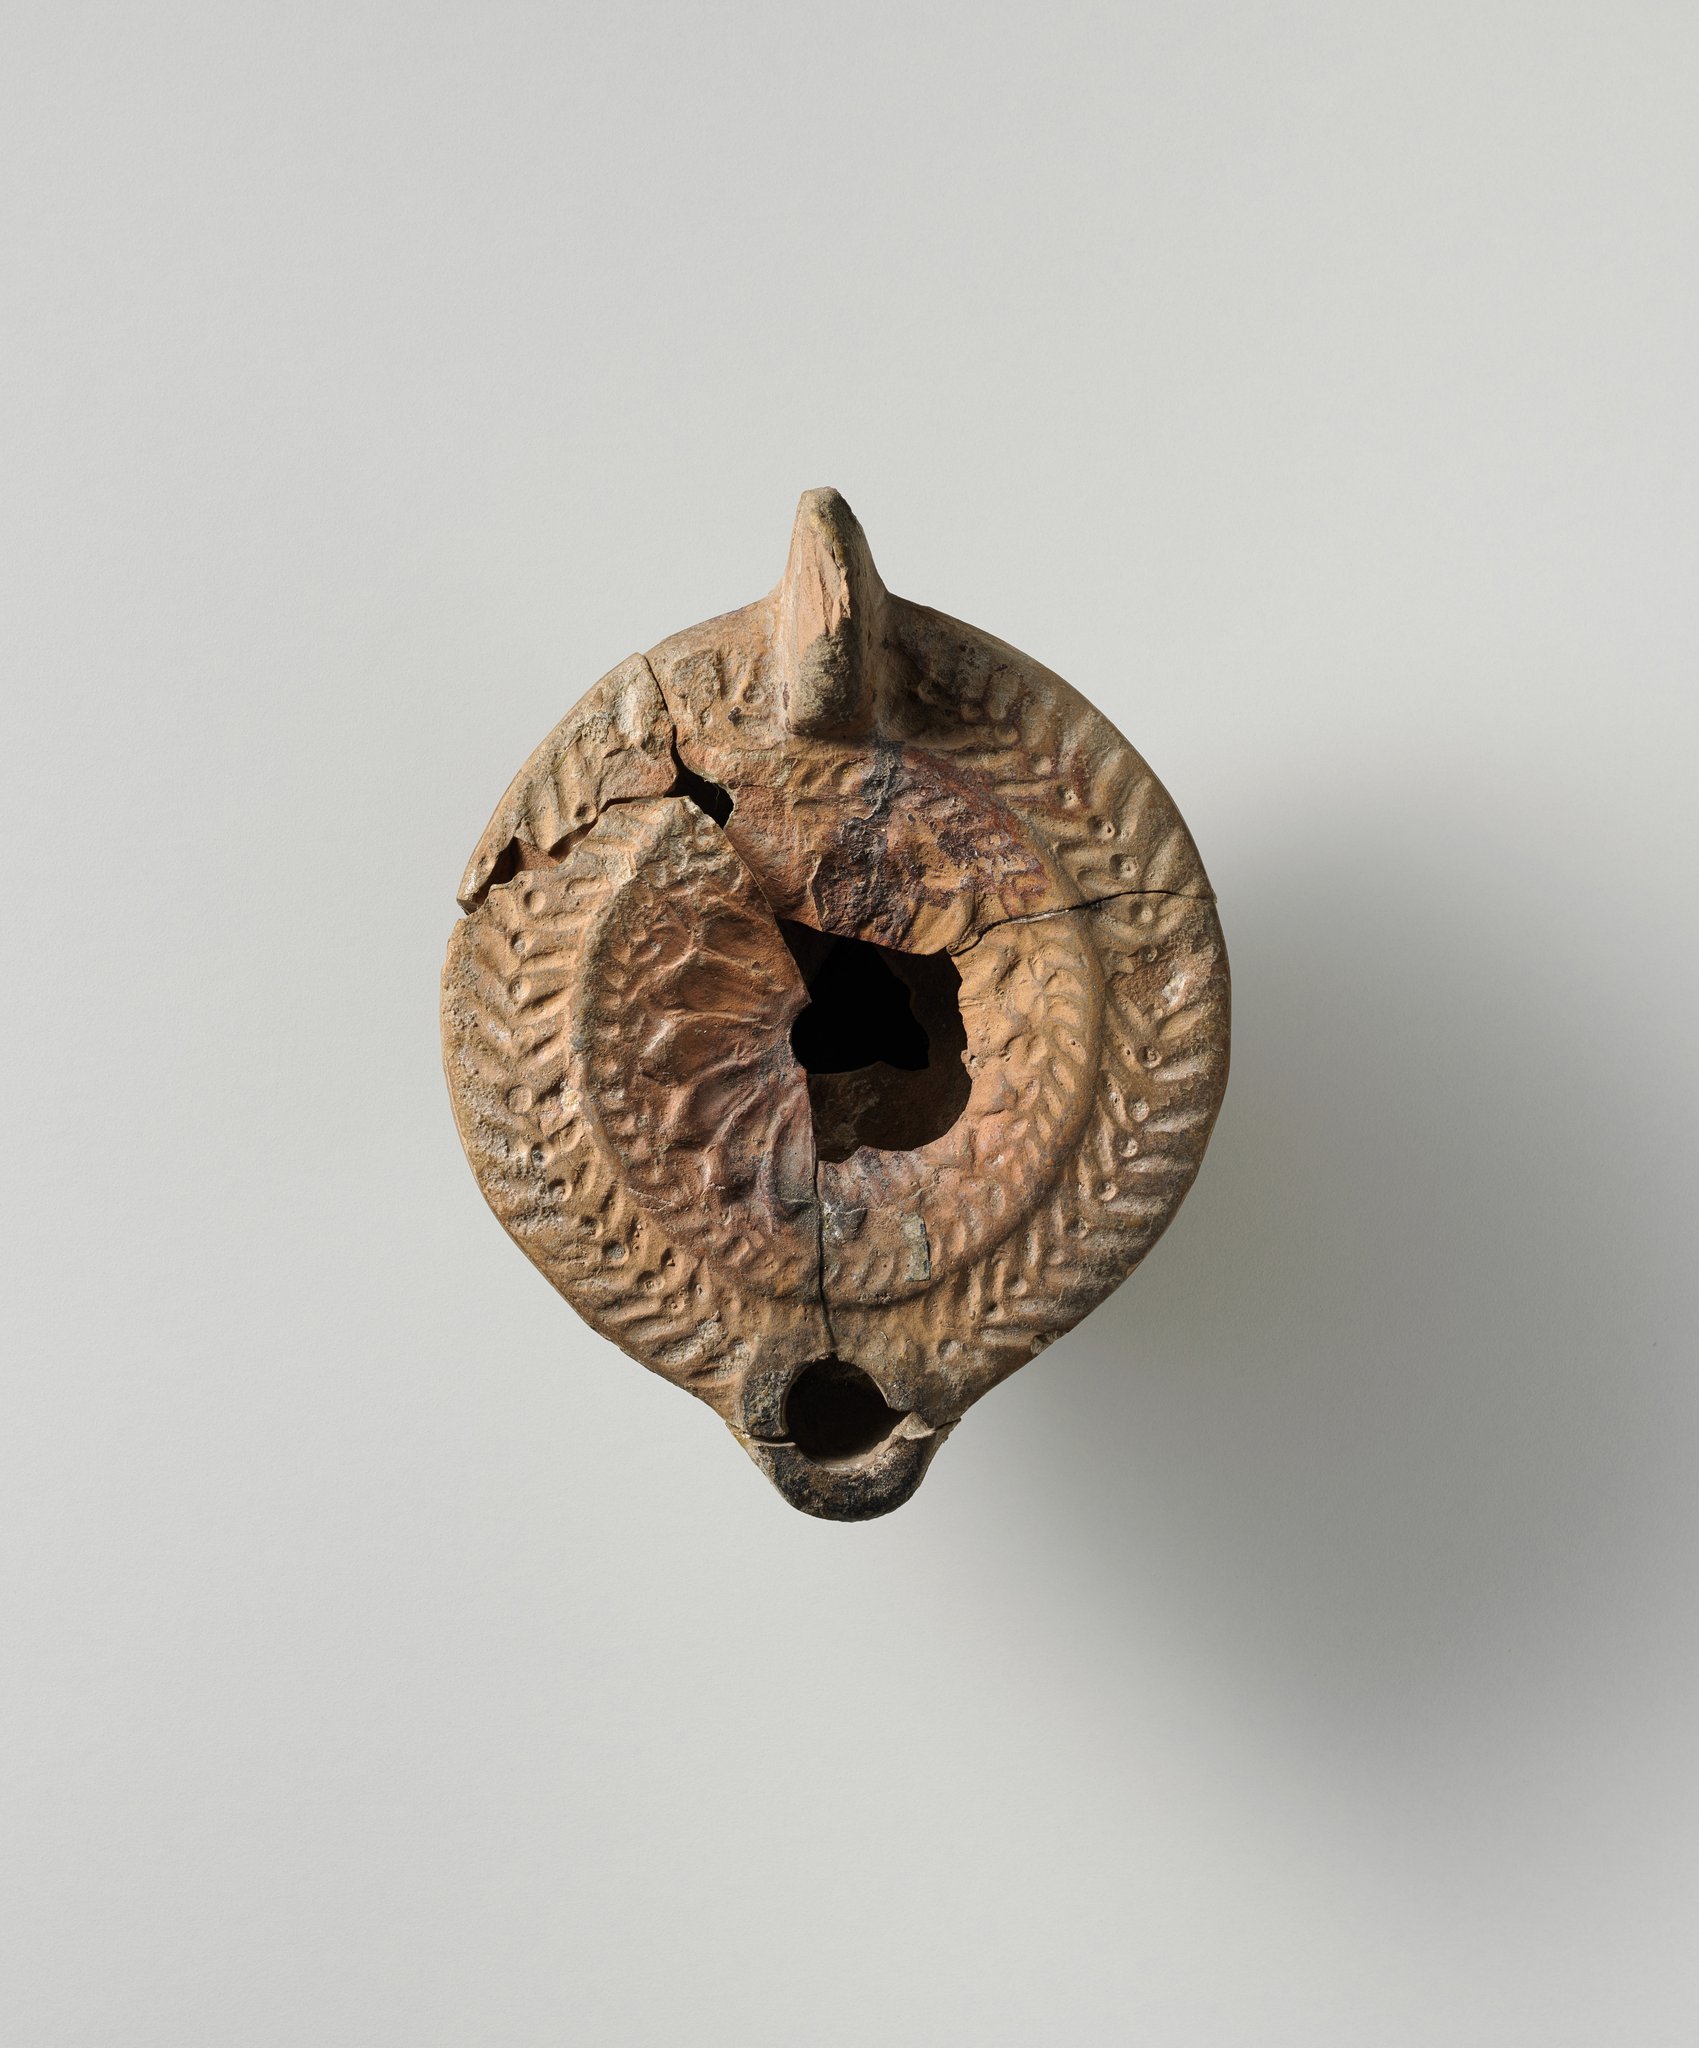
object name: lamp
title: Terracotta oil lamp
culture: roman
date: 201-250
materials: terracotta